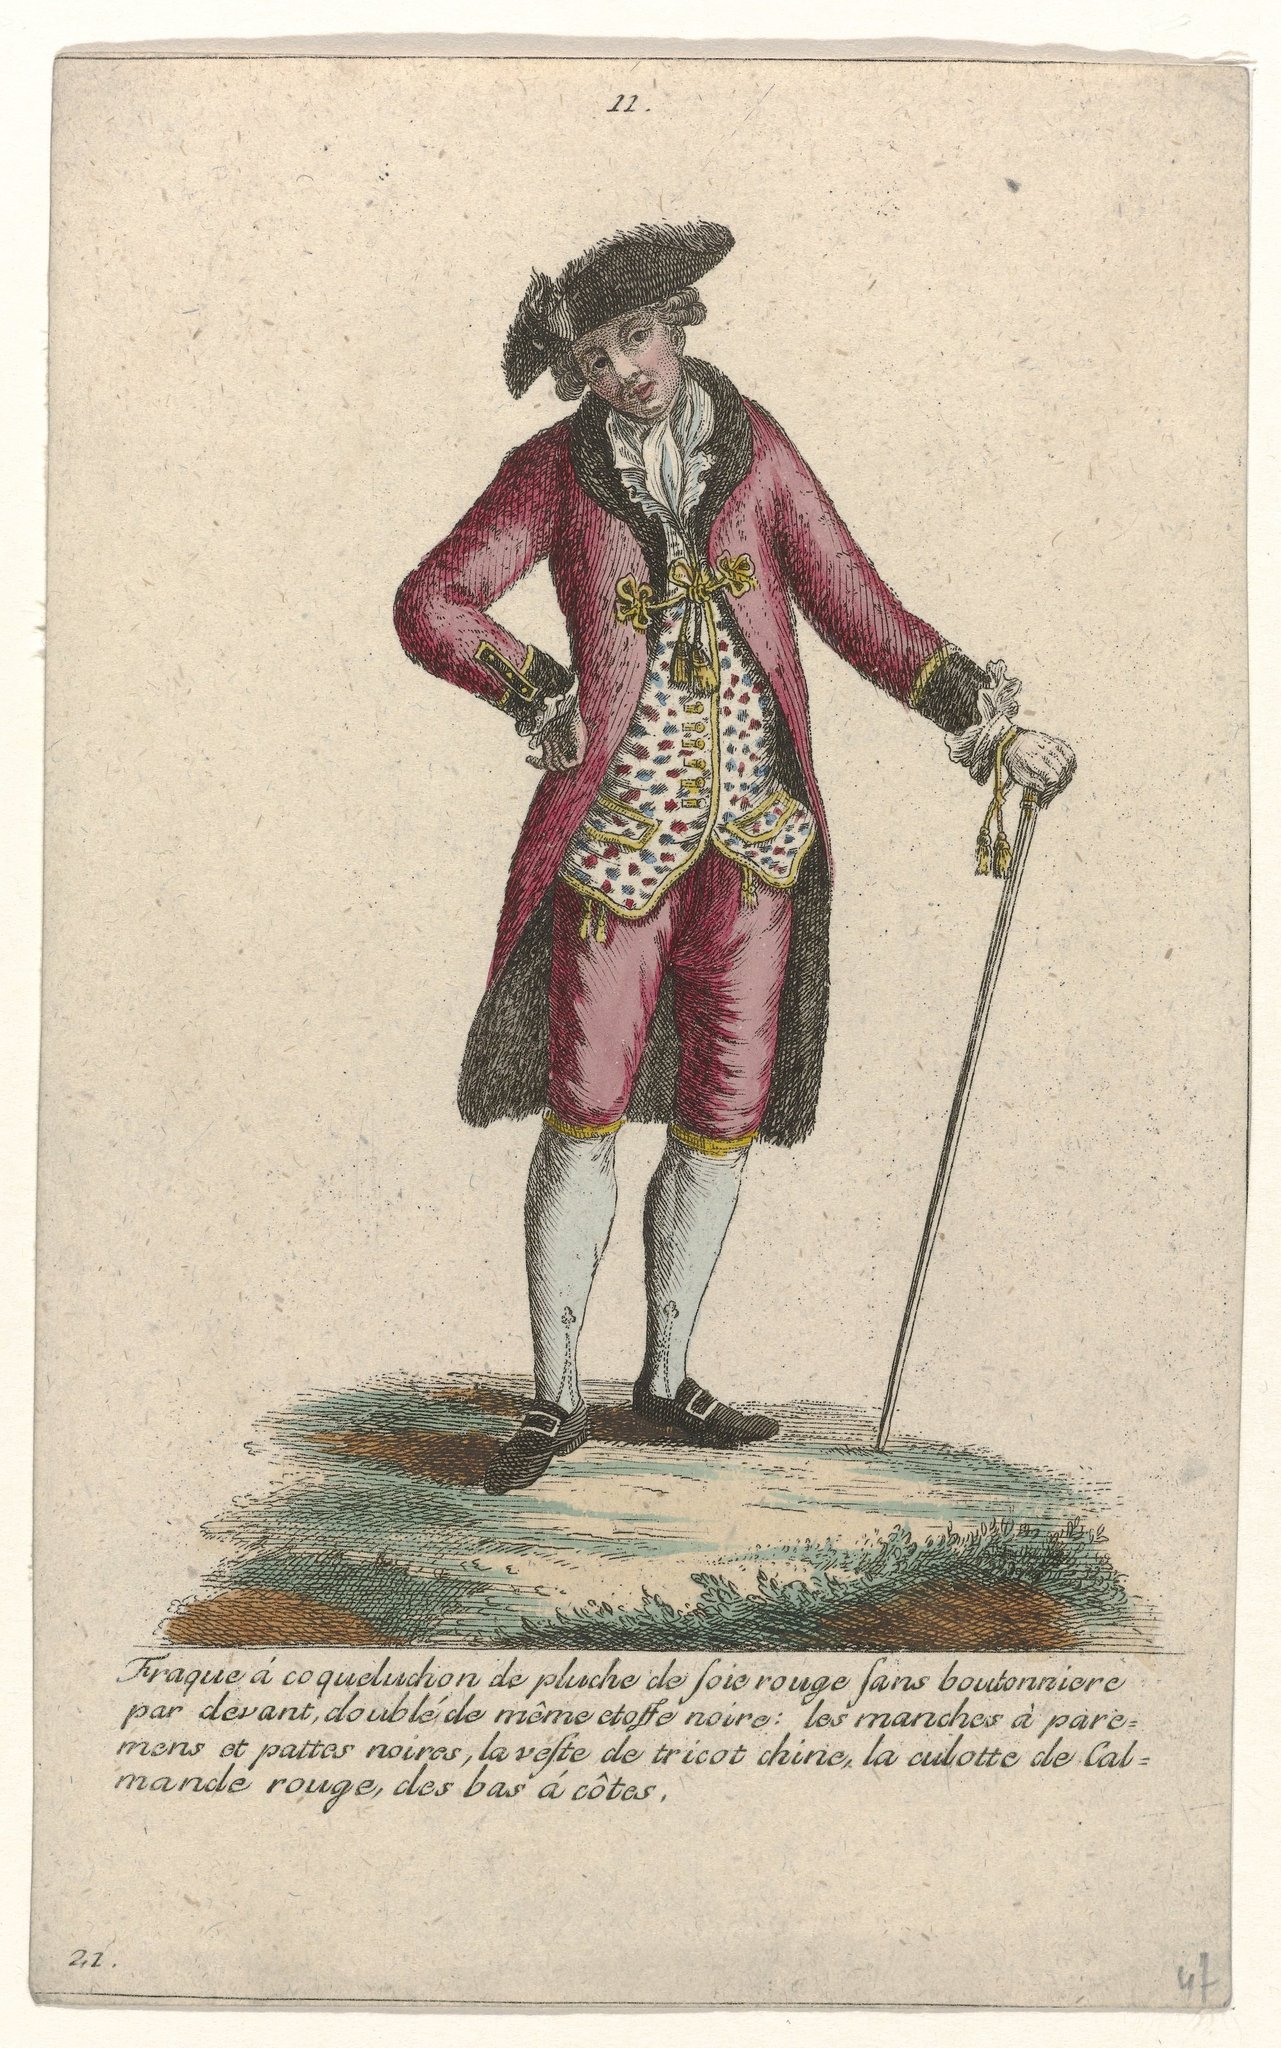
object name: fashion print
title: Gallerie des Modes et Costumes Français, 1785, nr. 11, nr. 21, Kopie naar R 99 : Fraque a coqueluchon de pluch (...)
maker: pierre gleich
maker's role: print maker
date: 1785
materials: paper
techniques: engraving, hand coloring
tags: clothing for the upper part of the body (vest) (+ men's clothes), coat (frac) (+ men's clothes), head-gear: hat (+ men's clothes), fashion plates, trousers, breeches, etc. (breeches) (+ men's clothes), stockings, socks (+ men's clothes), walking-stick, staff, cane (+ men's clothes)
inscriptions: caption: ‘Fraque a coqueluchon de pluche de soie rouge sans boutonniere par devant doublé de même etoffe noire : les manches à paremens et pattes noires, la veste de tricot chine, la culotte de Calmande rouge, des bas á côtes.’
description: Man gekleed in een frak met kraag ('coqueluchon') van rode zijden pluche zonder knopen; manchetten en voering van dezelfde zwarte stof. Hieronder een vest van 'tricot chine' op een rode kniebroek. Gerimpelde jabot en manchetten. Kousen met versierde klinken. Accessoires: hoed, wandelstok met lint en kwasten, breloques, schoenen met vierkante gespen. Kopie naar R 99 uit serie R. 17e Cahier des Costumes Français, 11e Suite d'Habillemens à la mode en 1779, Gallerie des Modes et Costumes Français.